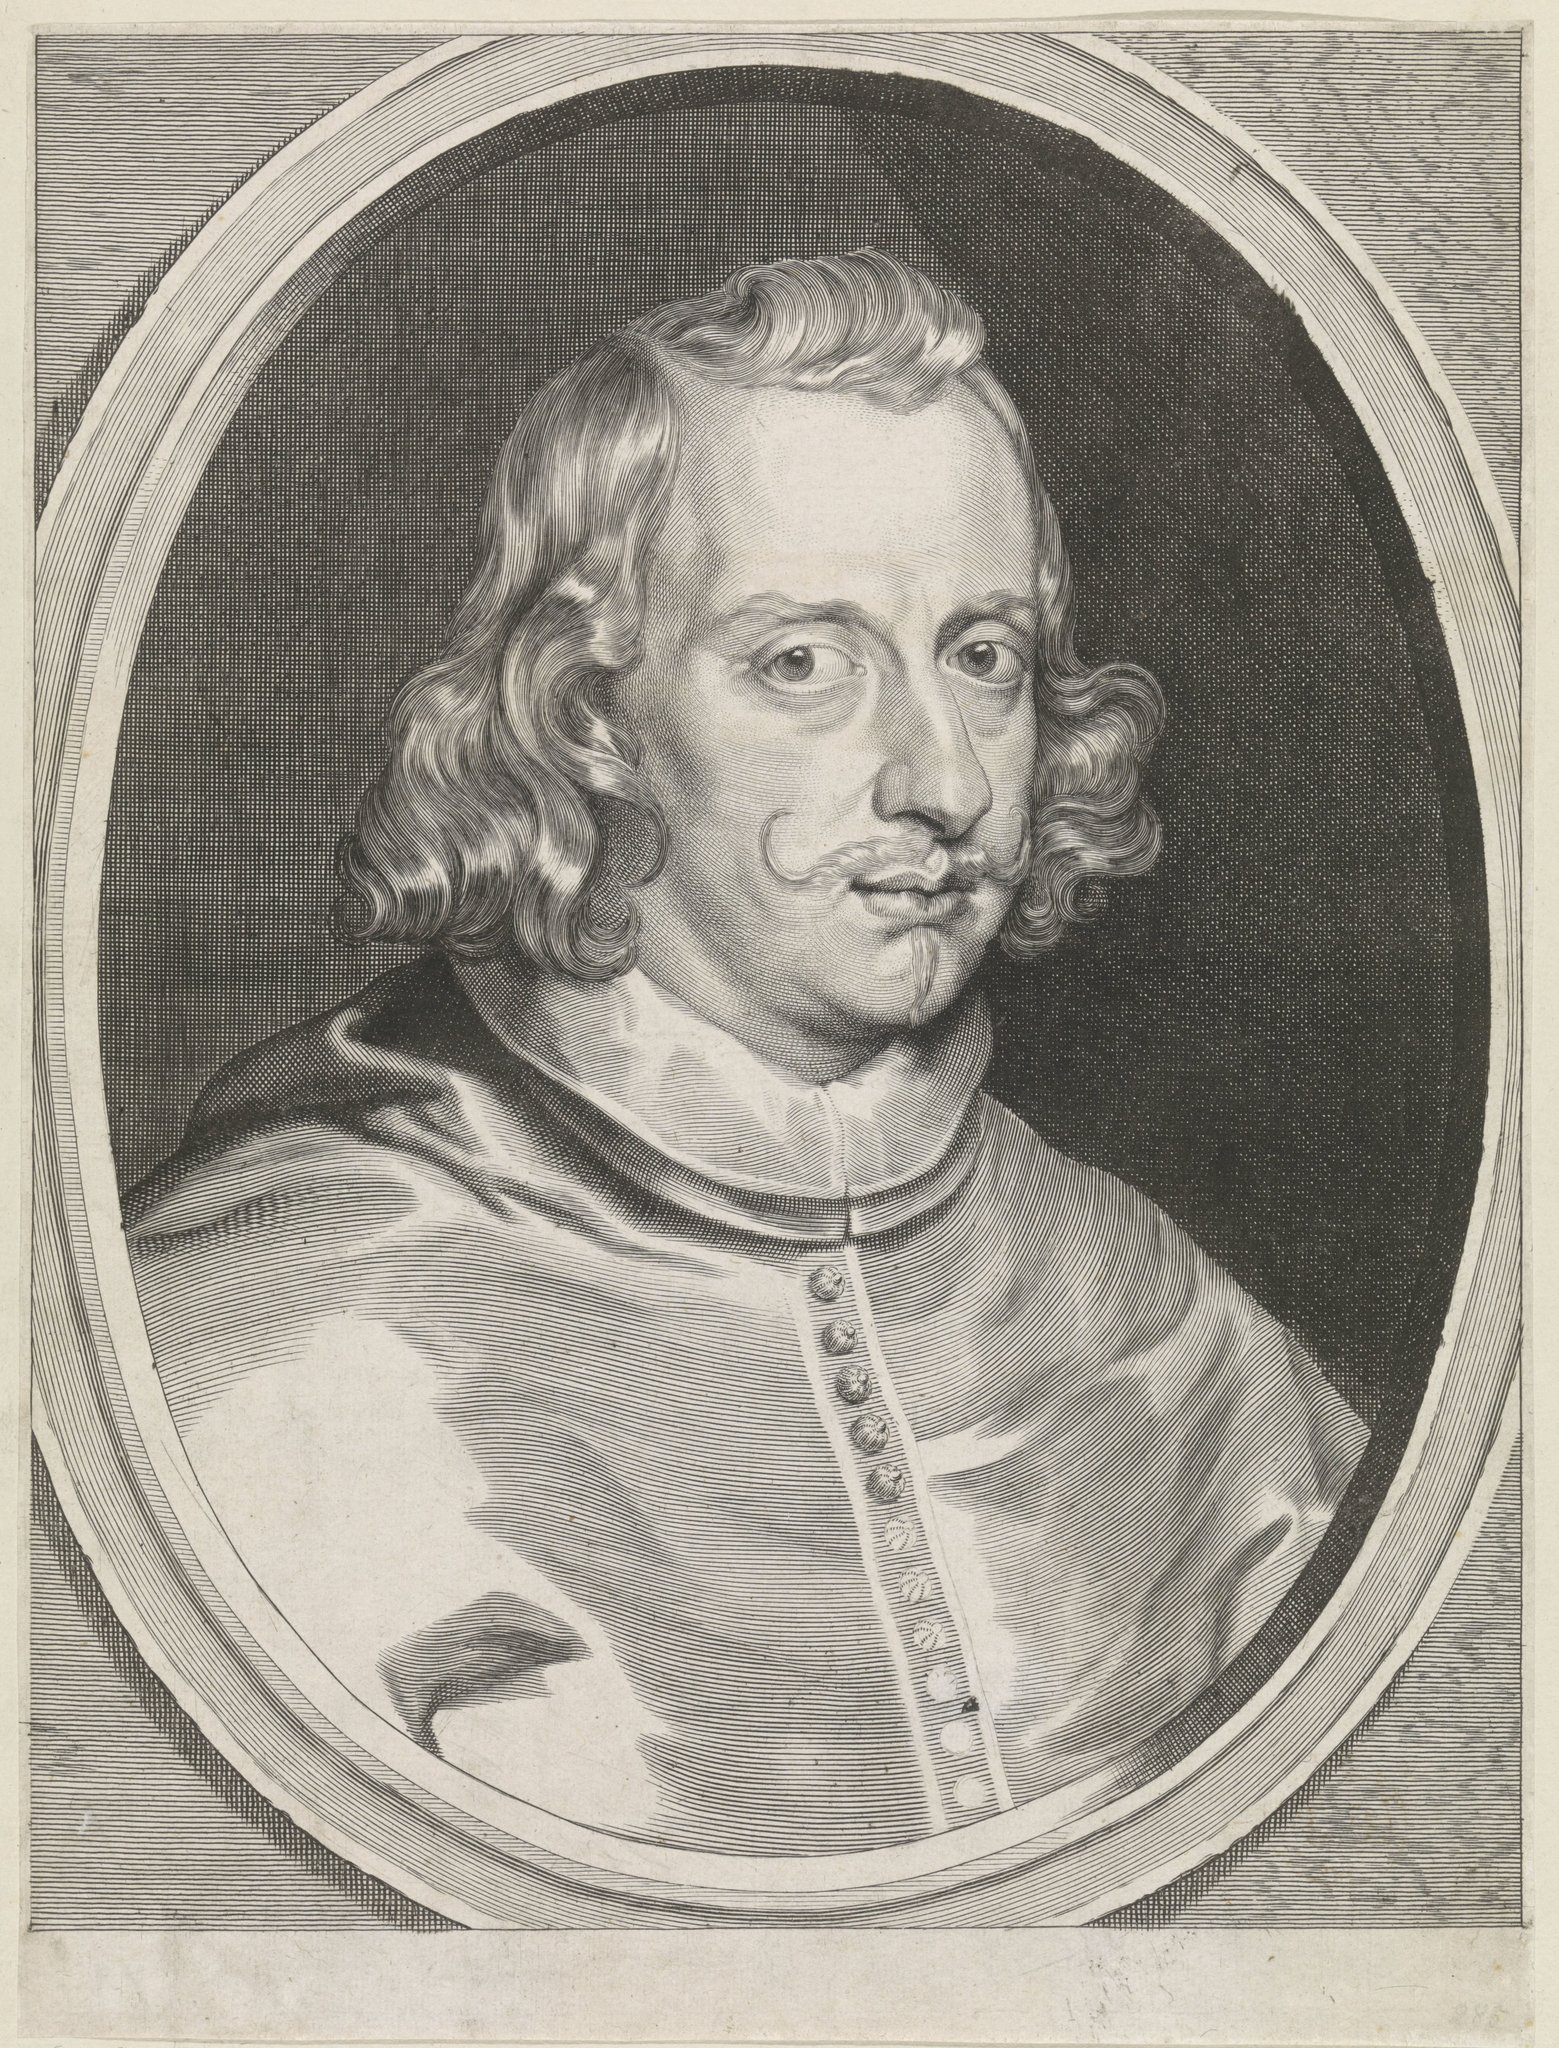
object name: print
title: Portret van de kardinaal-infant Ferdinand van Oostenrijk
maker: paulus pontius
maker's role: draughtsman, print maker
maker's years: 1603-1658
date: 1616-1657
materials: paper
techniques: engraving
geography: antwerp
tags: brussels, landvoogd der zuidelijke nederlanden ferdinand van oostenrijk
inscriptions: collector's mark: Lugt 240